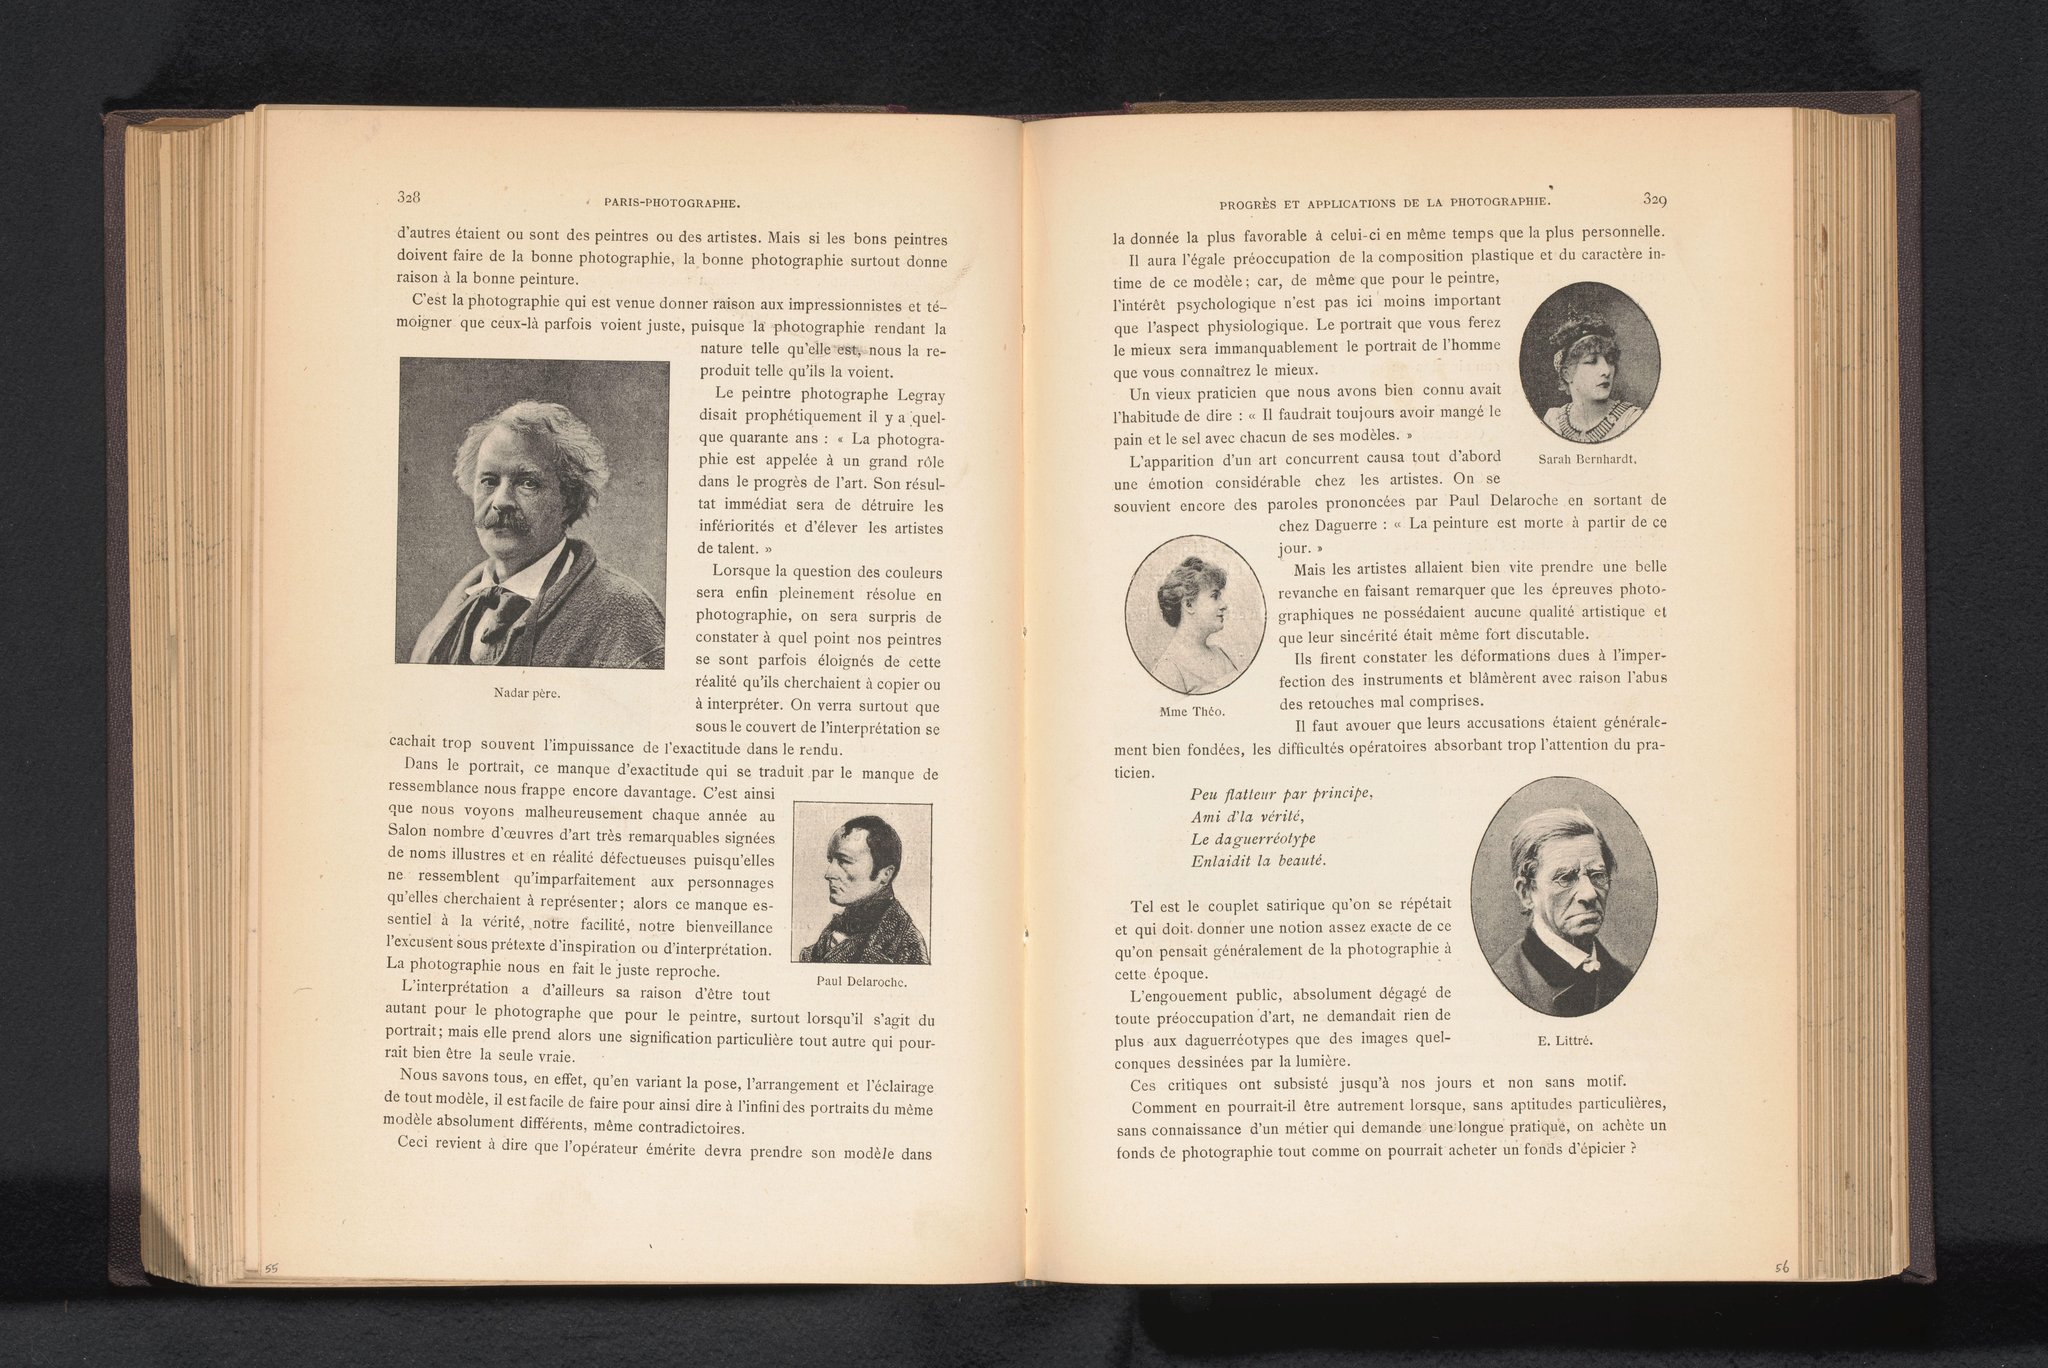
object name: photomechanical print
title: Portret van vermoedelijk Nadar en een fotoreproductie van een portret van Paul Delaroche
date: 1882-1892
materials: paper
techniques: autotype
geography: france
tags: félix nadar, paris, painter, draughtsman, sculptor, paul delaroche, artist (in general)